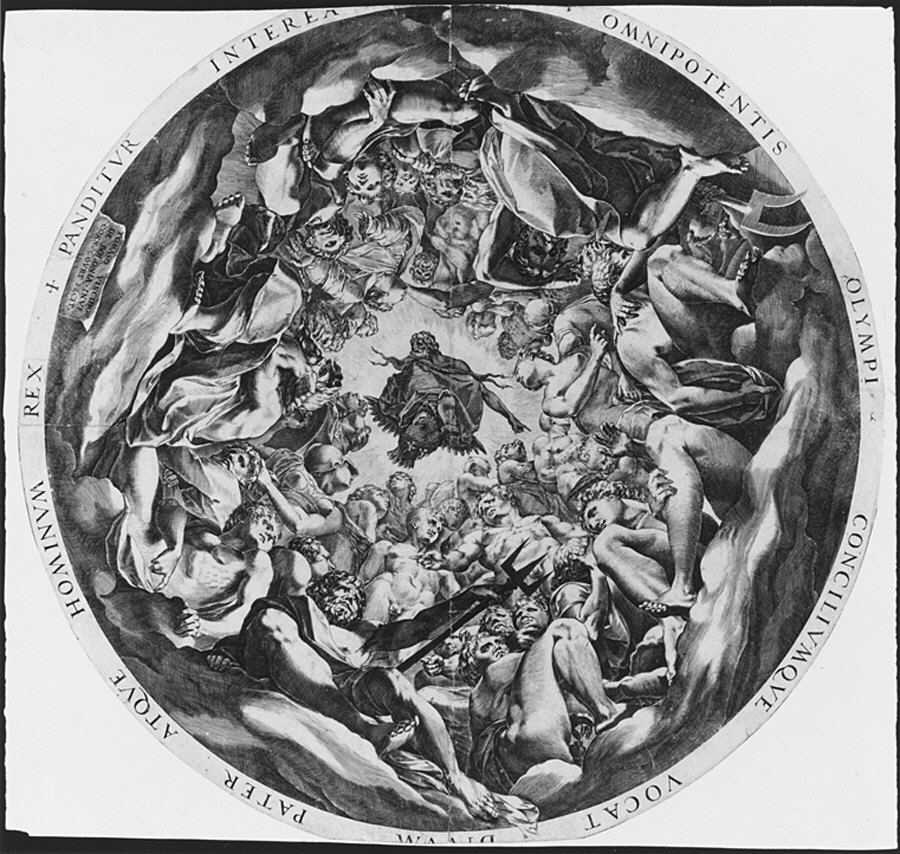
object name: print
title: Concourse of the Gods on Mount Olympus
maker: cornelis cort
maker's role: artist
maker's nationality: netherlandish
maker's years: 1533-1578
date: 1565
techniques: engraving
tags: male nudes,gods